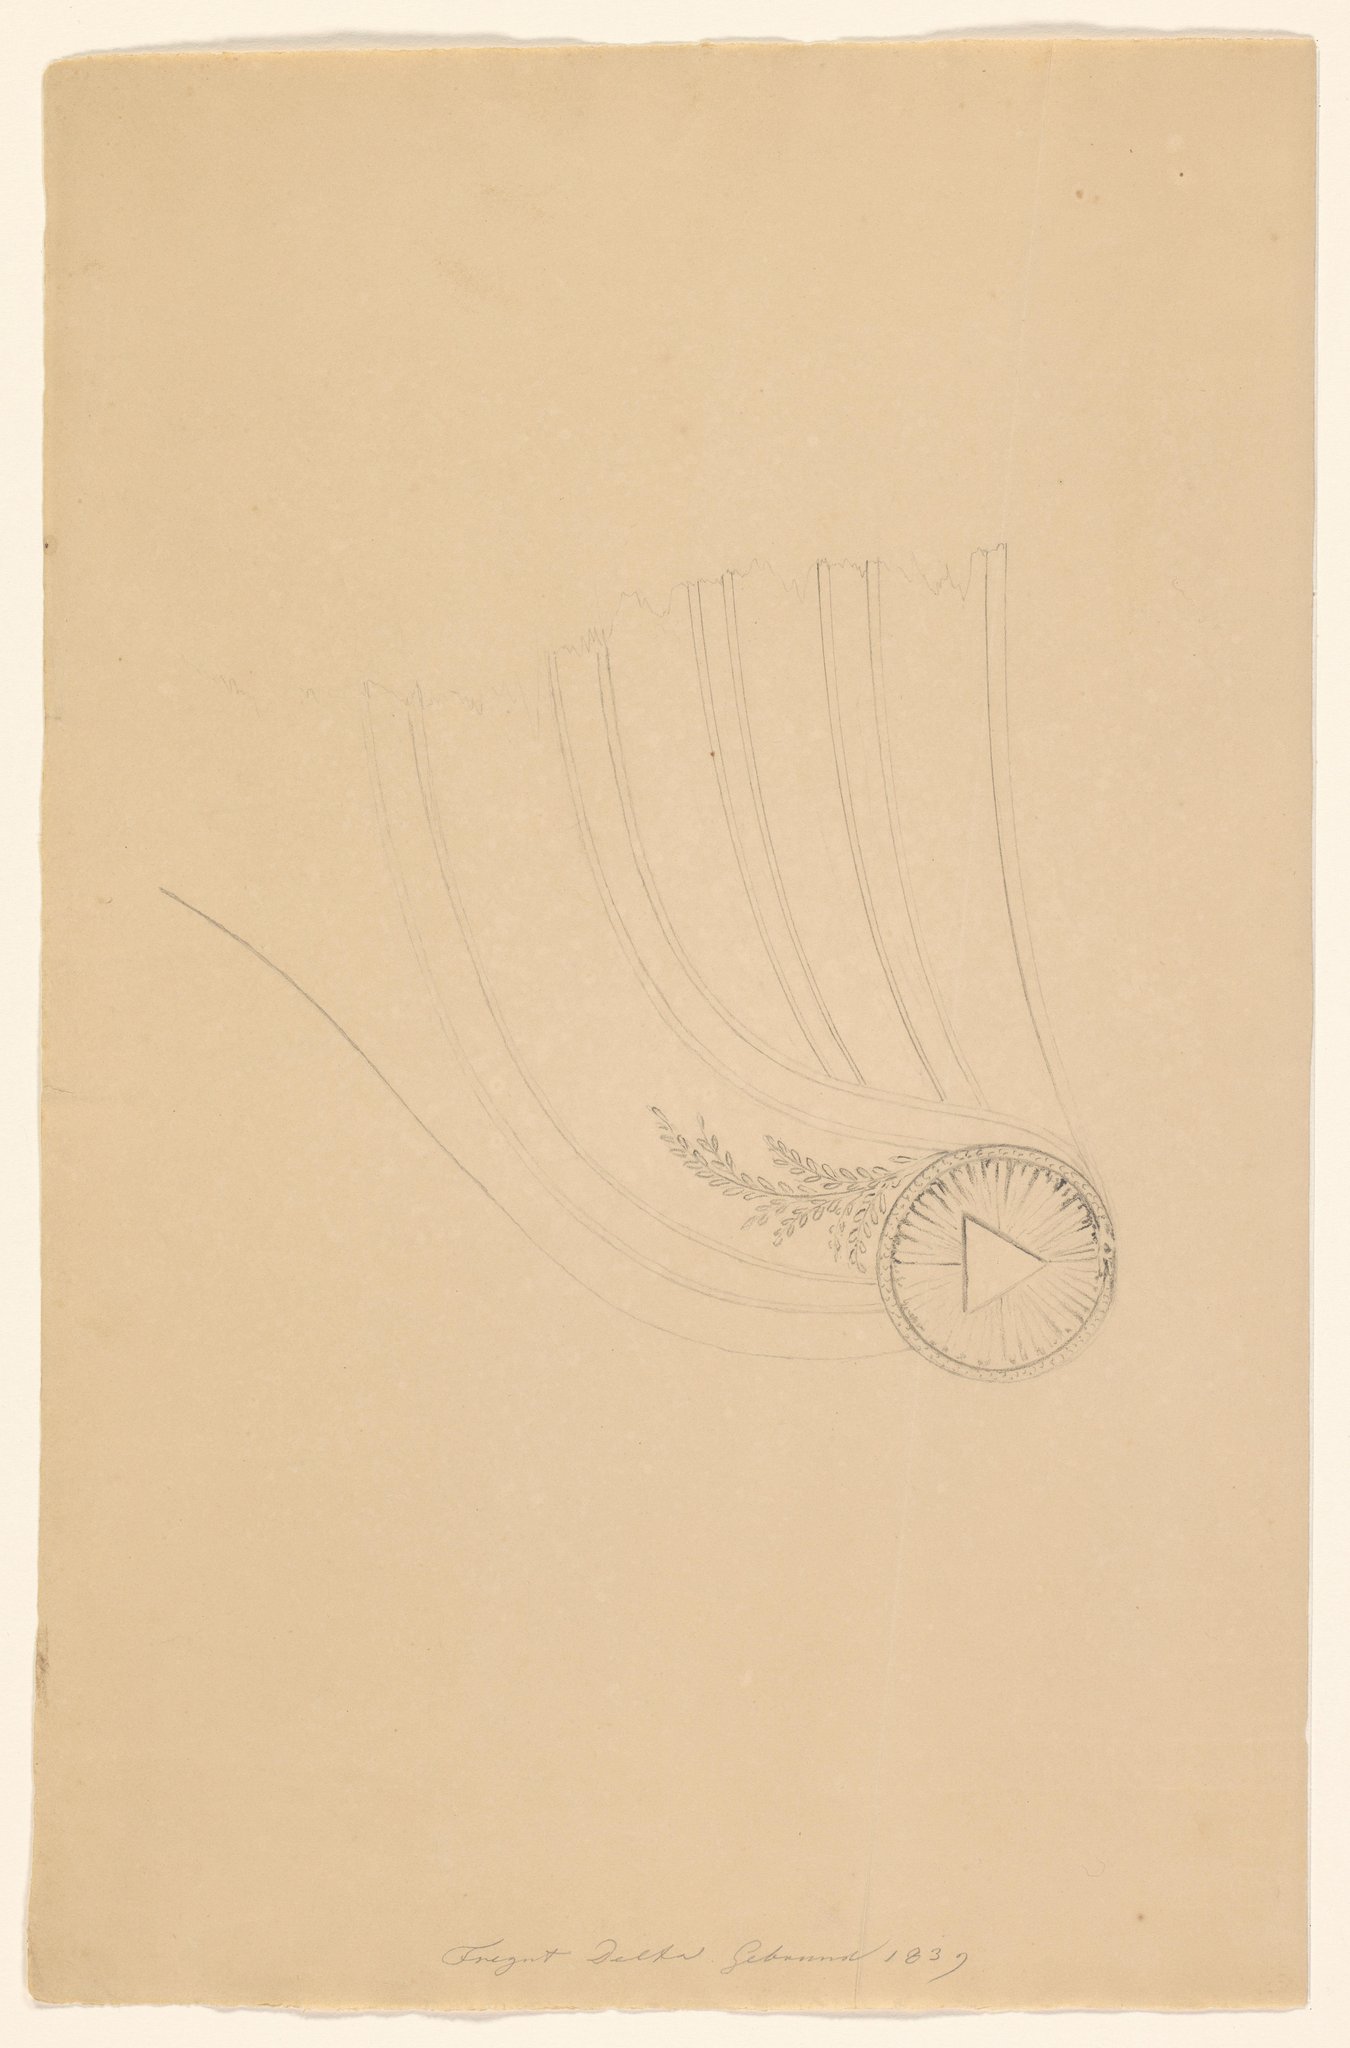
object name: design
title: Ontwerp voor de boeg van het fregat Delta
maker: a.j. schouten (1775-1849)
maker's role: architect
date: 1839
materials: chalk, paper, pencil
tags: parts of ship's exterior: bow, ornamenting, decorating ~ applied arts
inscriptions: inscription: ‘Fregat Delta gebouwd 1839’, watermark